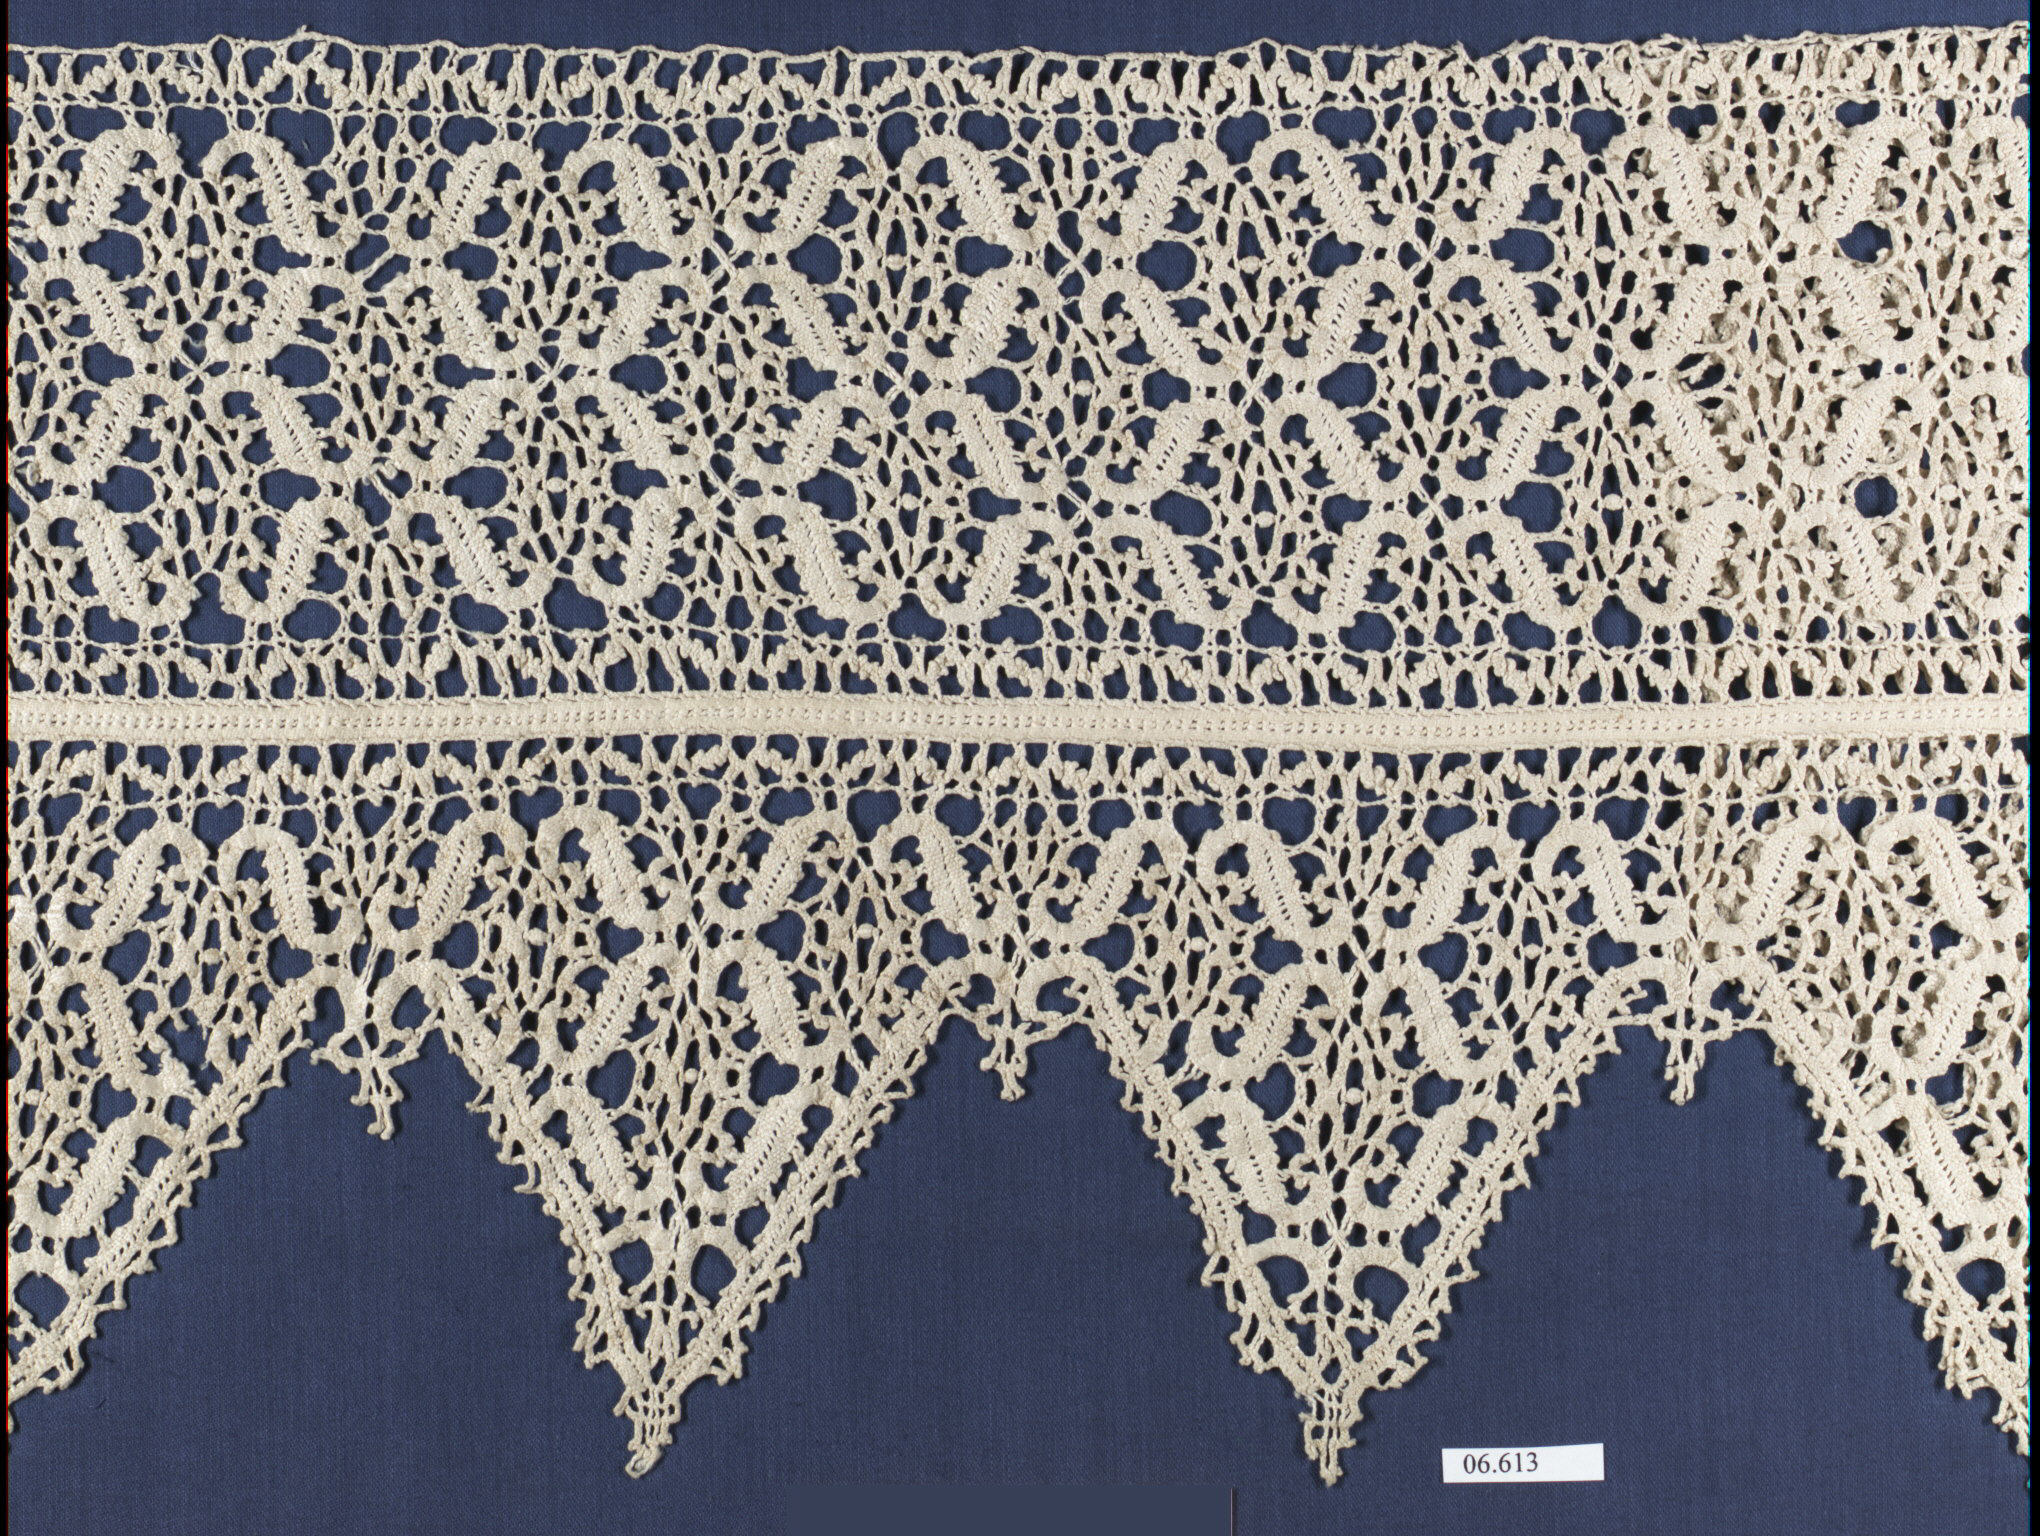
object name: band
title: Band with border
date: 1634-1666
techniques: lace